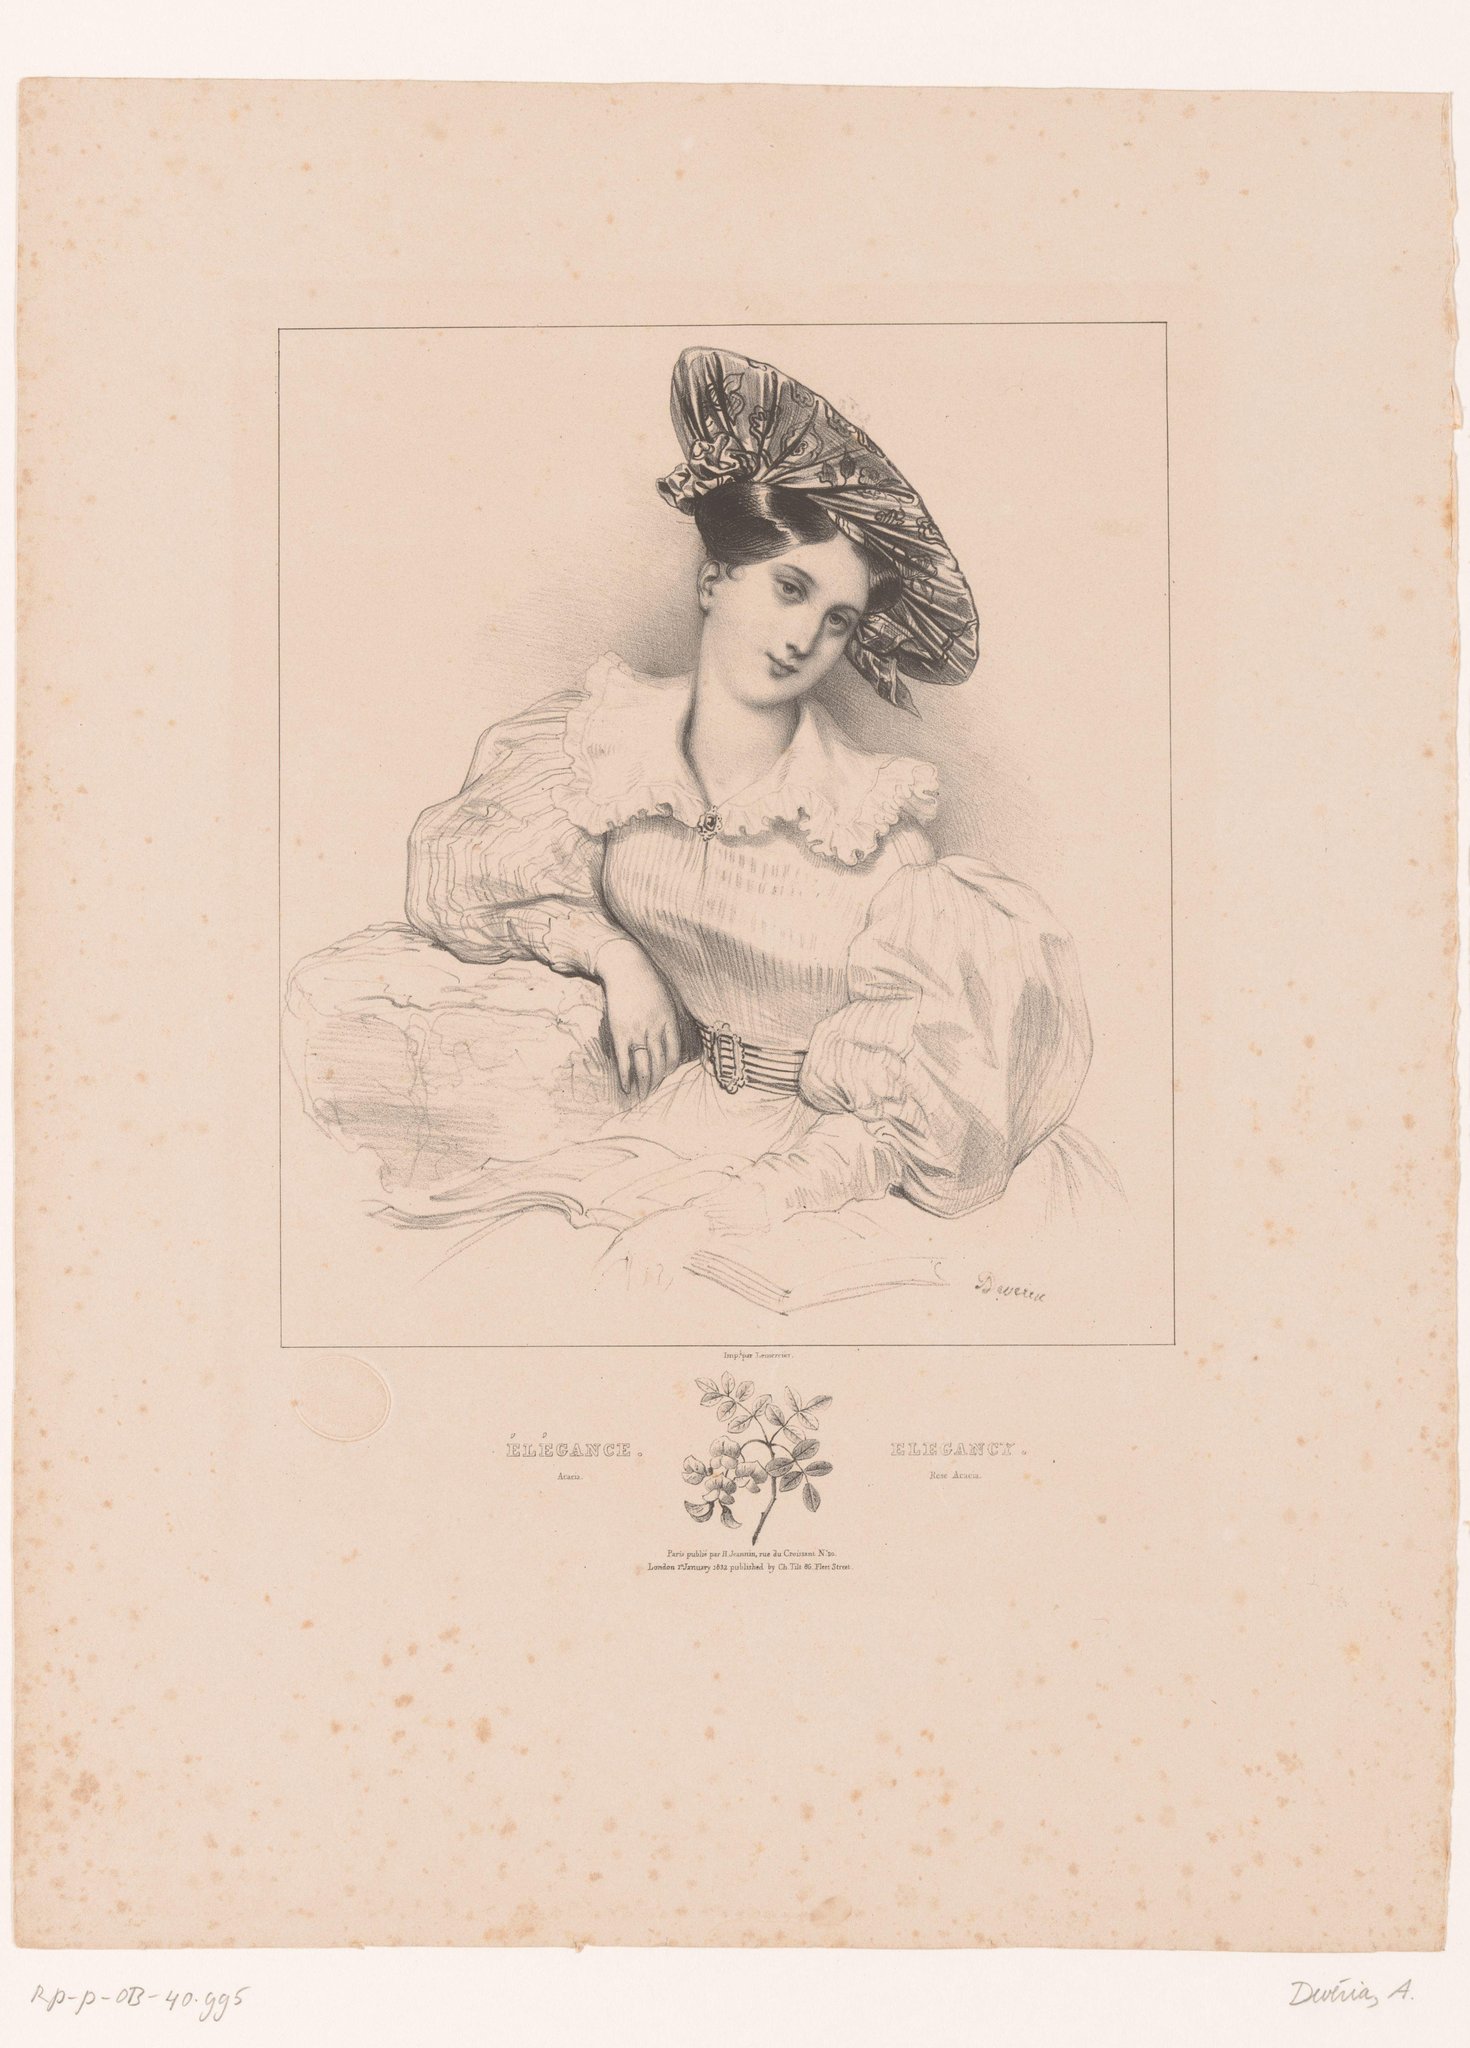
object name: print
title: Élégance. Acacia / Elegancy. Rose Acacia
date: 1831-1832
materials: paper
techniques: lithograph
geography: paris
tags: flowers, elegance, historical persons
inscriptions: check stamp: Lugt 3987